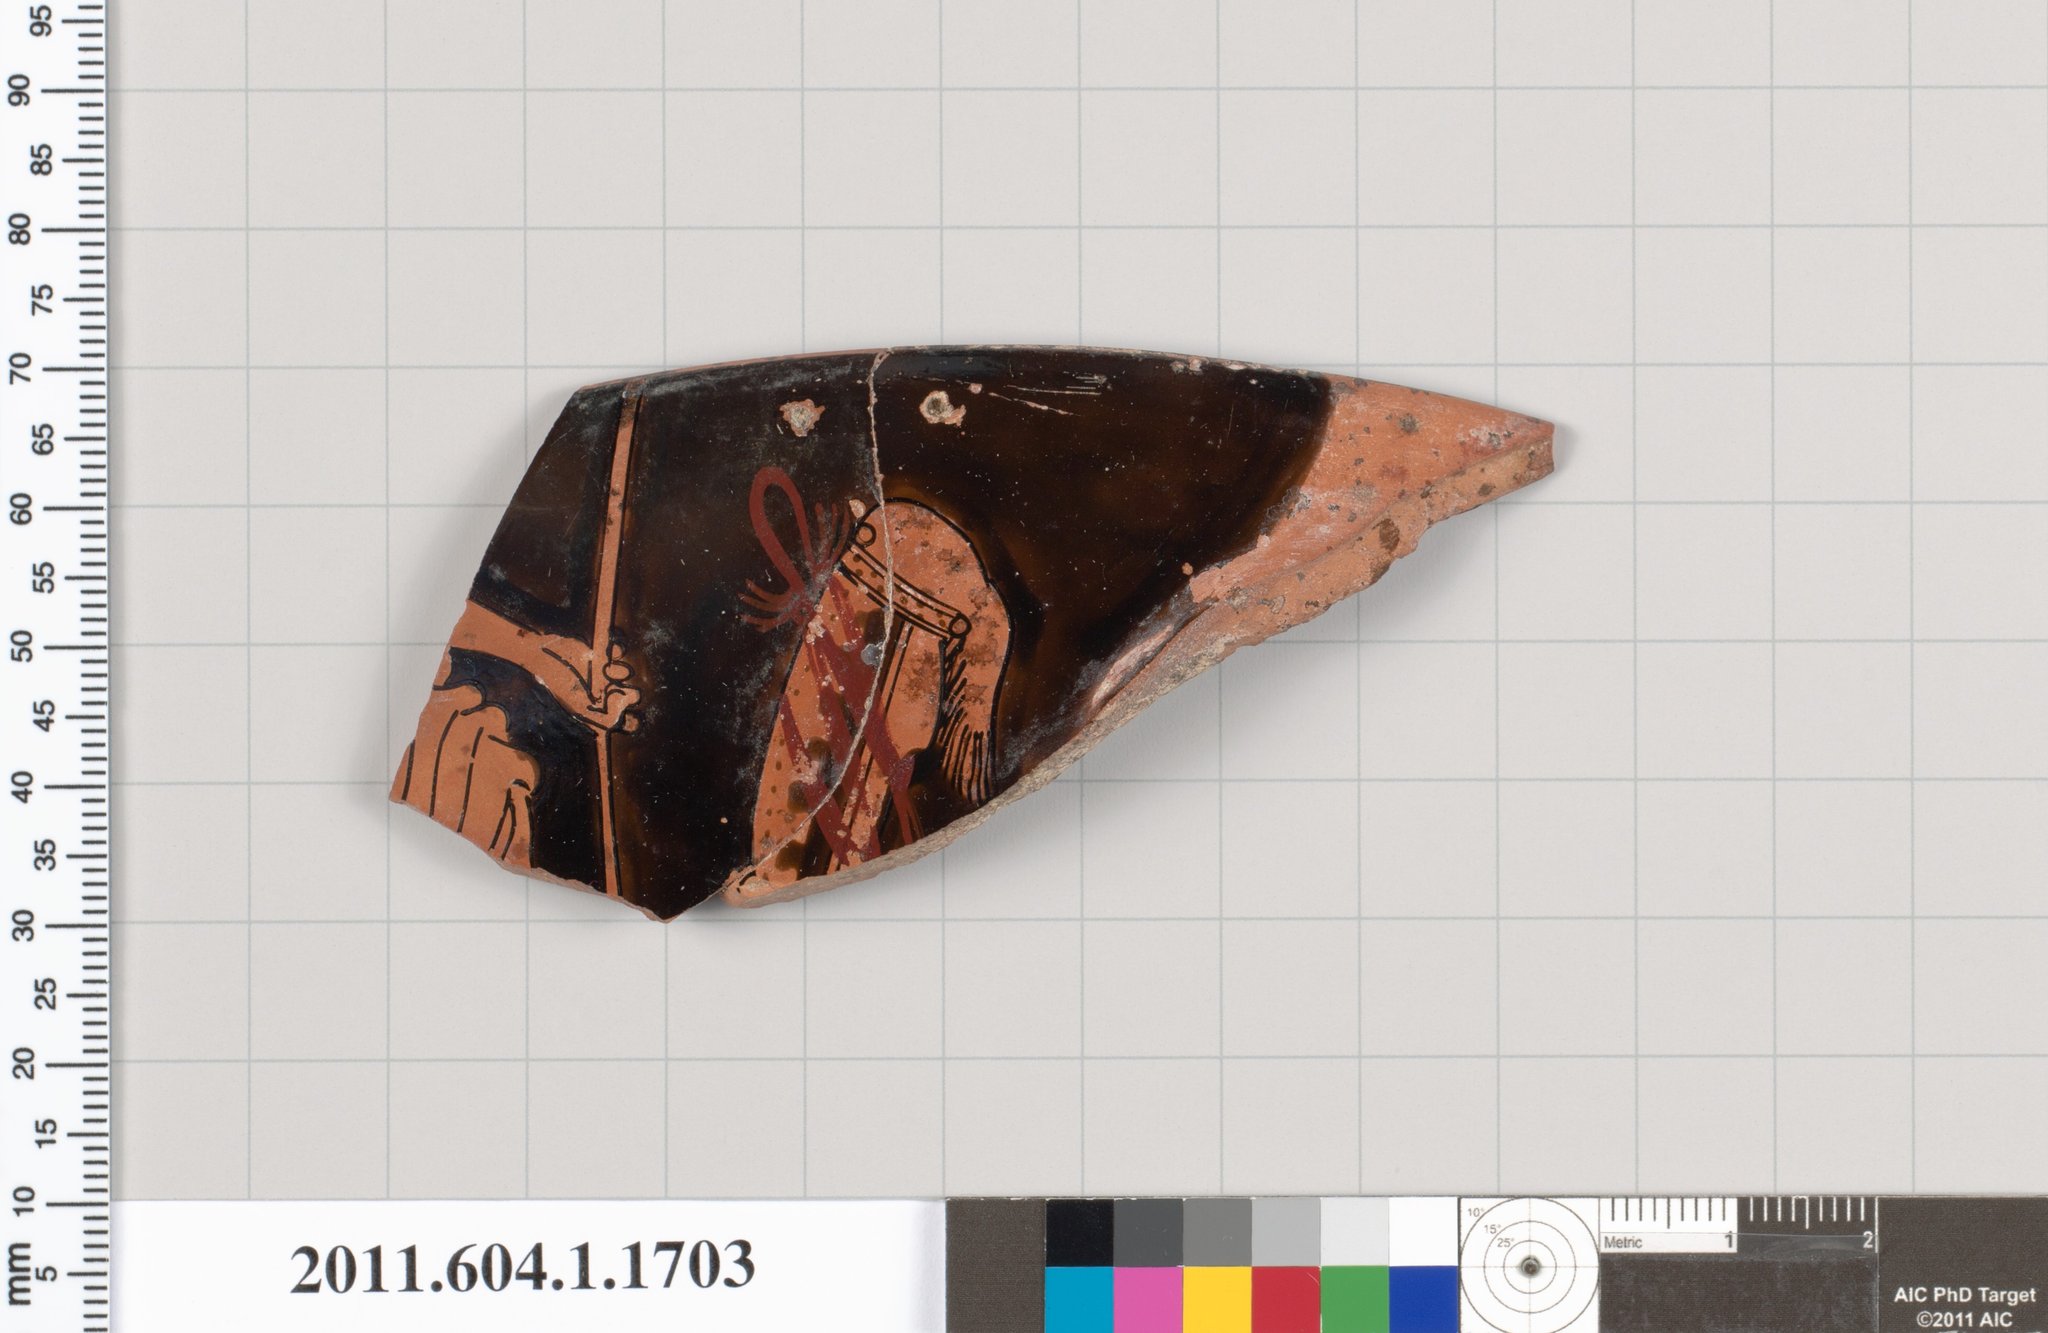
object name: kylix fragment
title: Terracotta rim fragment of a kylix (drinking cup)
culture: greek, attic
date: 490-480 BCE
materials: terracotta